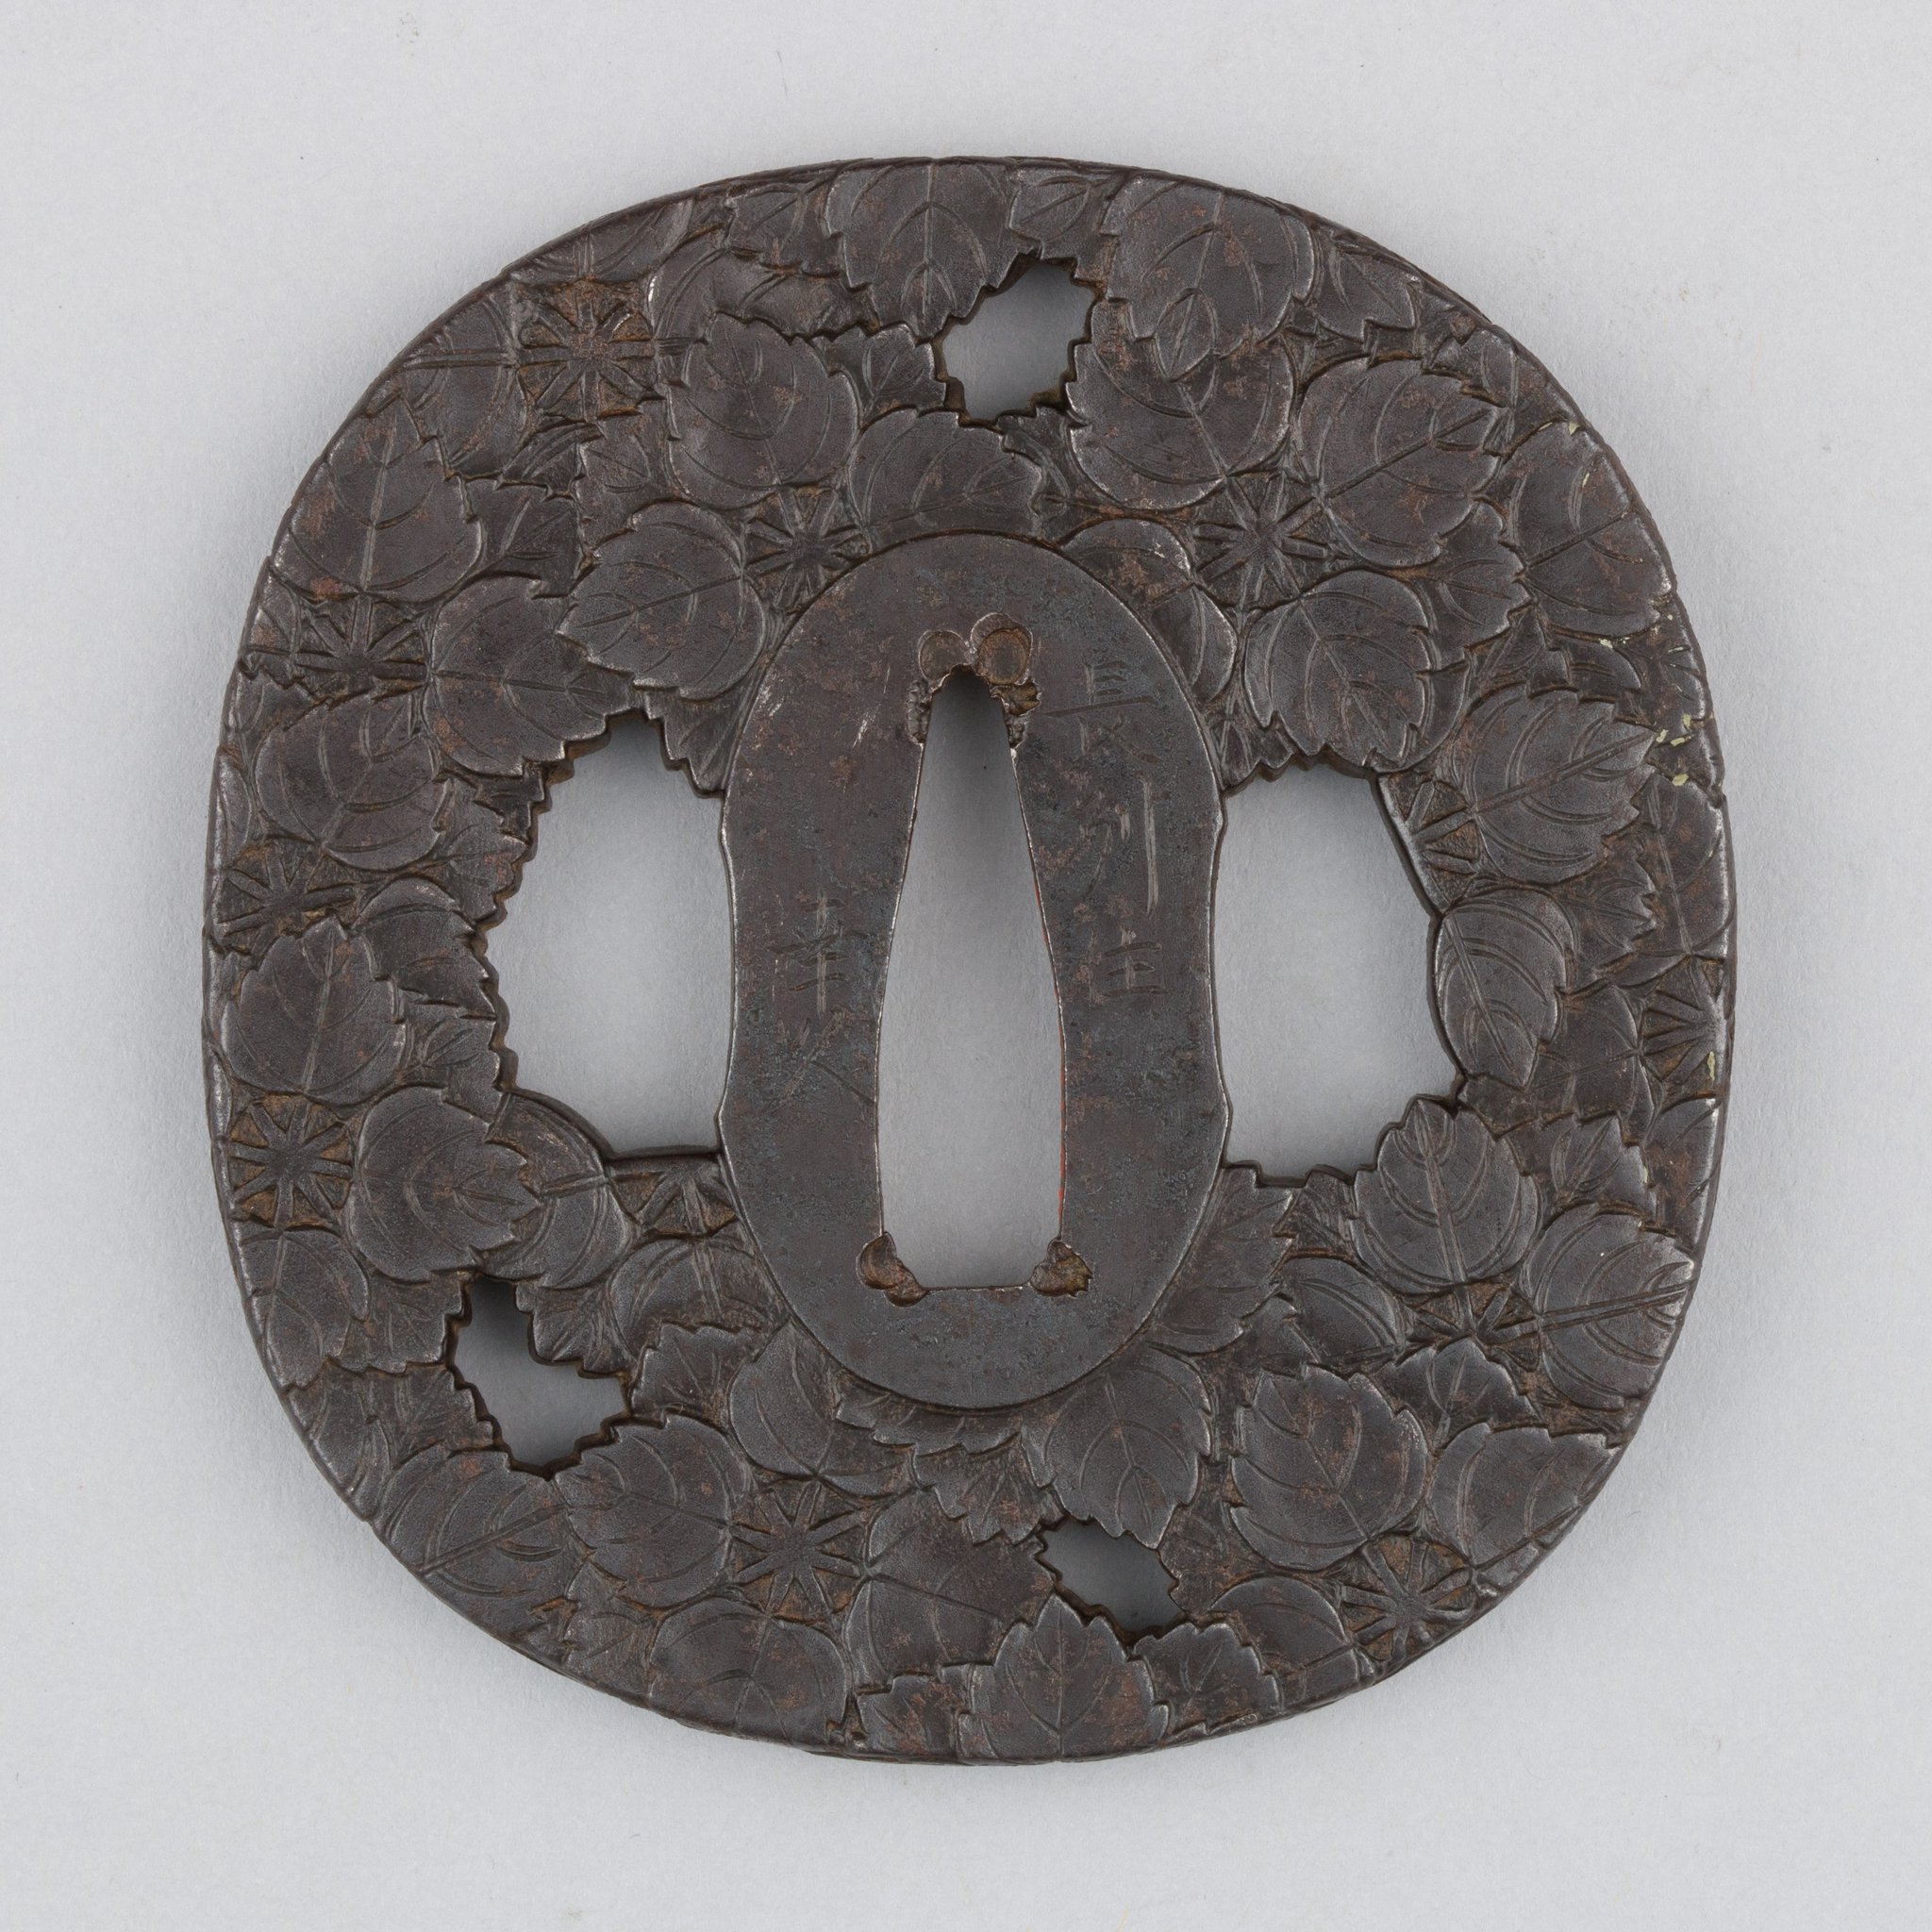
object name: sword guard tsuba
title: Sword Guard (Tsuba)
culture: japanese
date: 1701-1800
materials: copper, iron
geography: japan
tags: leaves